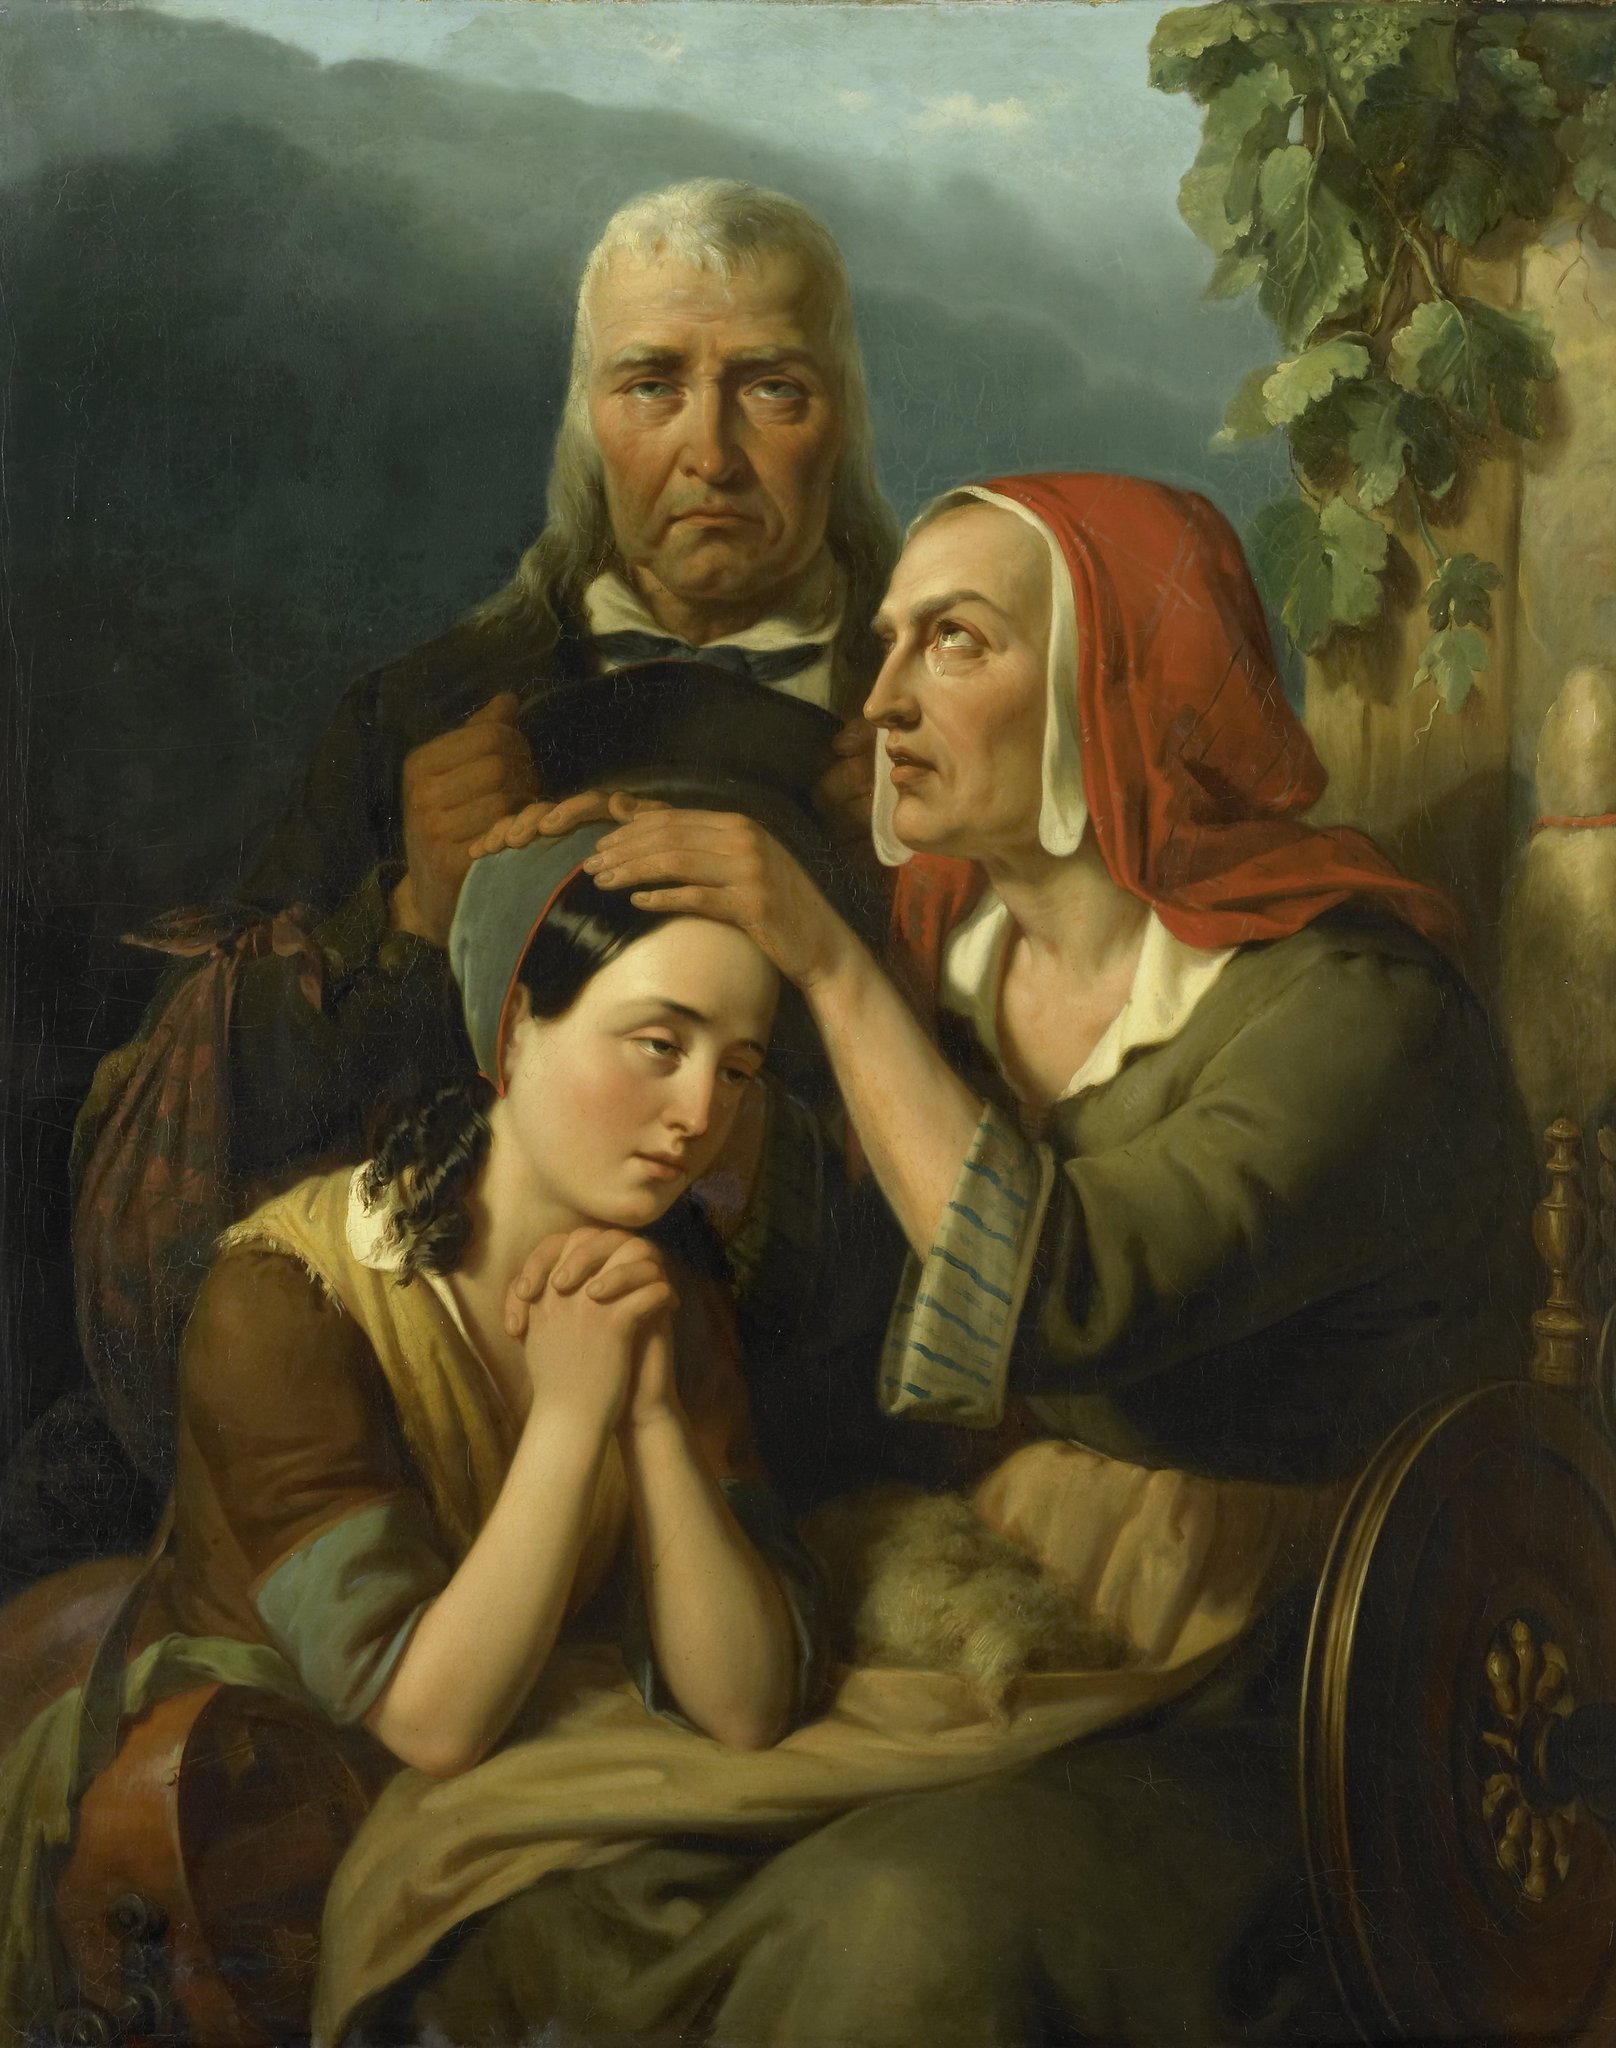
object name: painting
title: 'A Mother's Blessing'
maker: moritz calisch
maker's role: draughtsman, print maker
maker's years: 1819-1870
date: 1844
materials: canvas, oil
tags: family group, especially parents with their child(ren), parental blessings and admonitions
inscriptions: signature and date: ‘M. Calisch fec.t 1844’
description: Een meisje knielt bij haar moeder en ontvangt haar zegen. Achter haar staat de vader. Naast de moeder een spinnewiel.